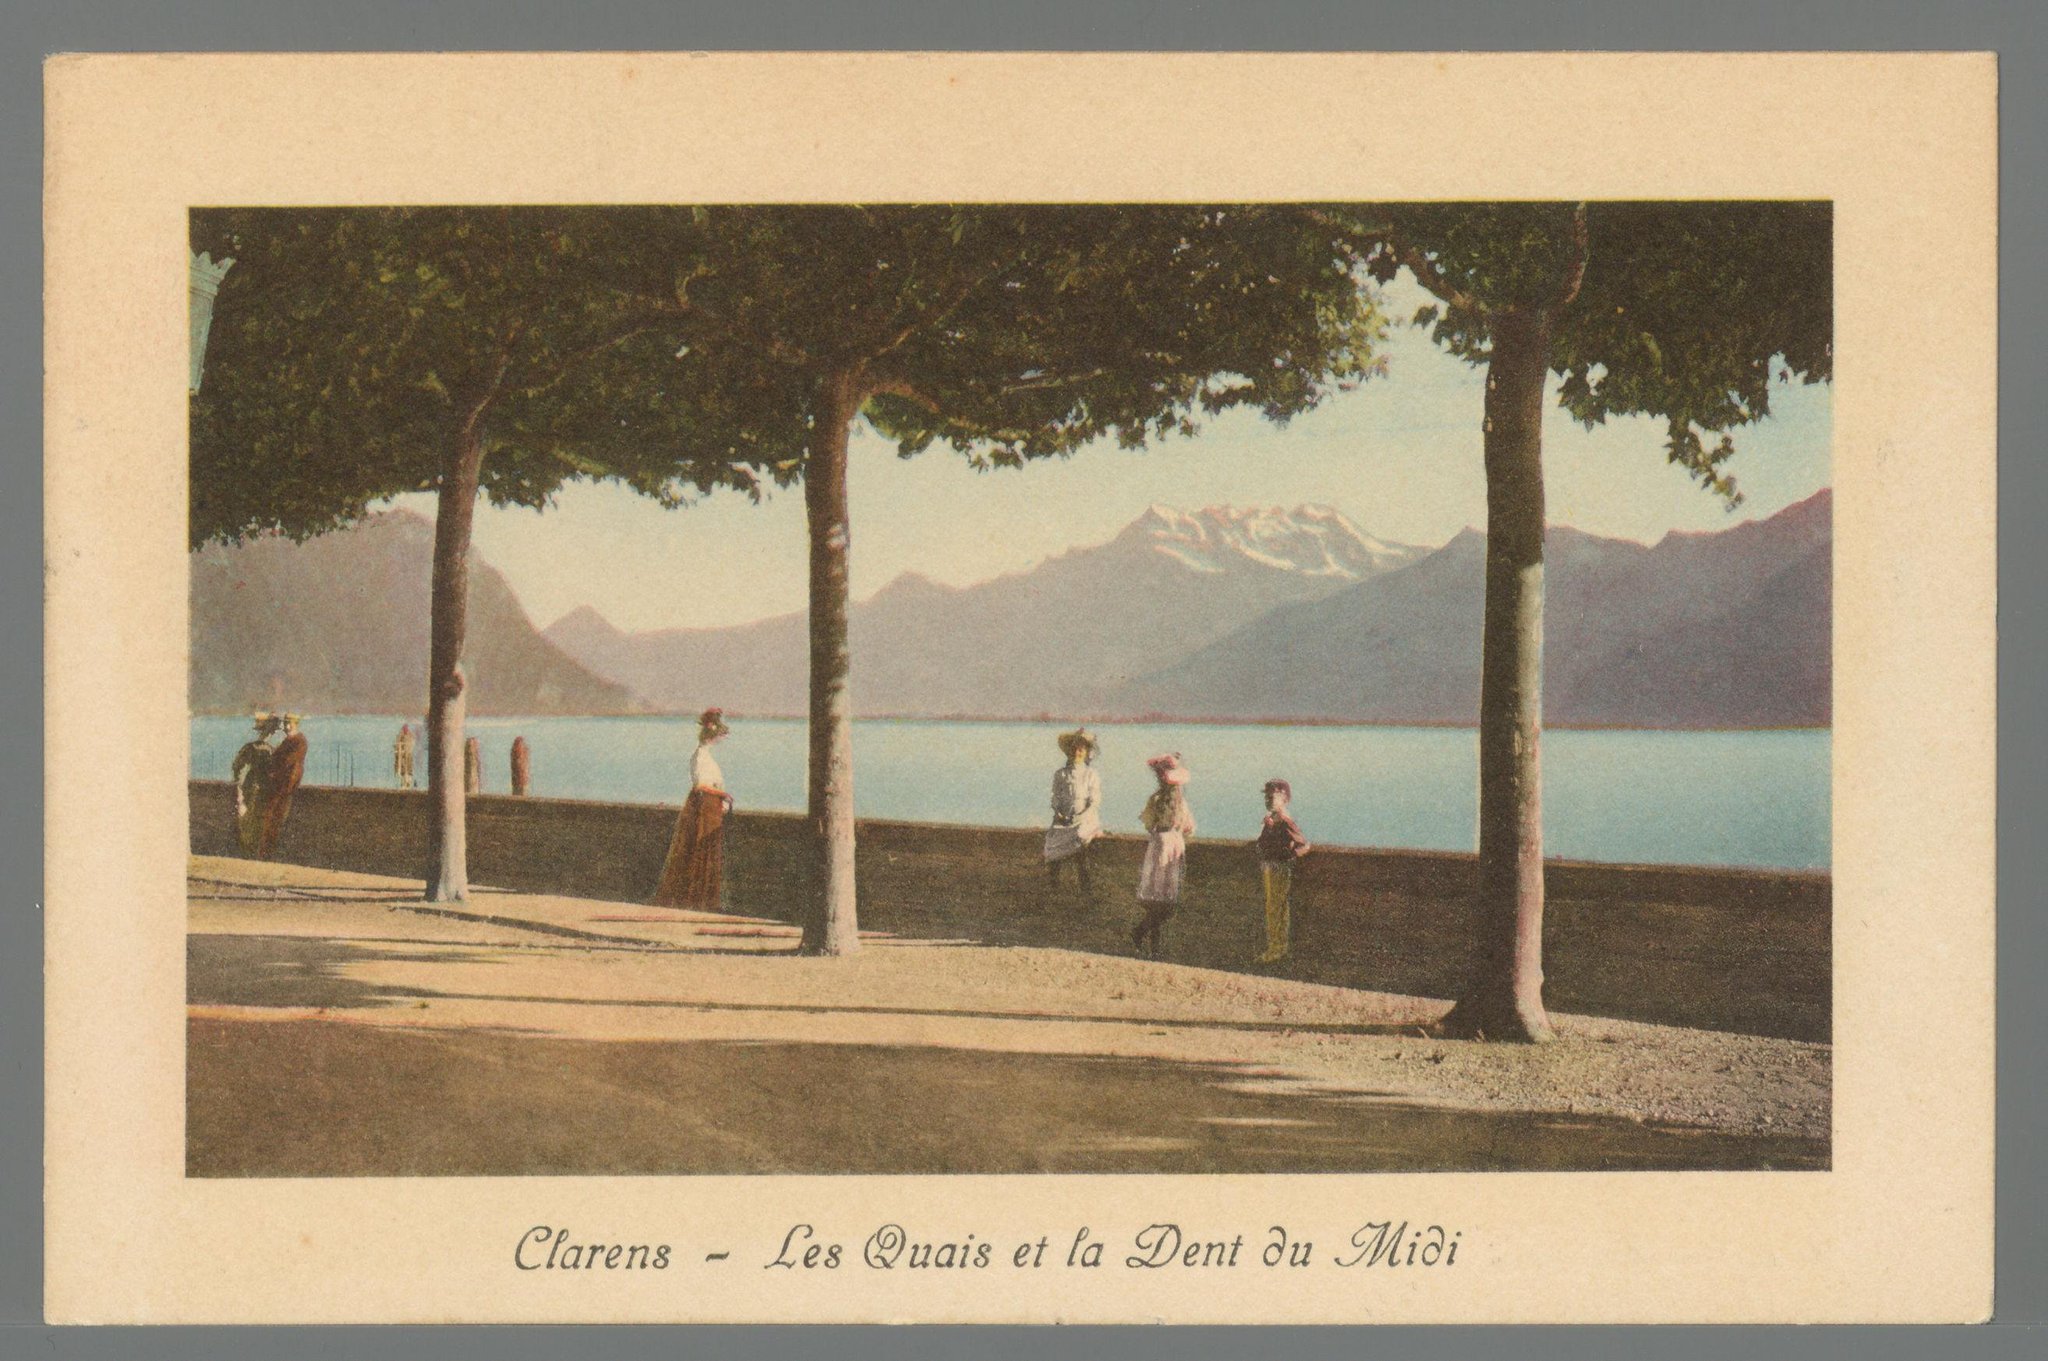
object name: ansichtkaart, prentbriefkaart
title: Clarens. Les Quais et la Dent du Midi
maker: Anonymous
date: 1905-1920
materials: cardboard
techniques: photograph, lithograph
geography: clarens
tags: public gardens, park (+ city(-scape) with figures, staffage), lake, mountain-range, snow peaks